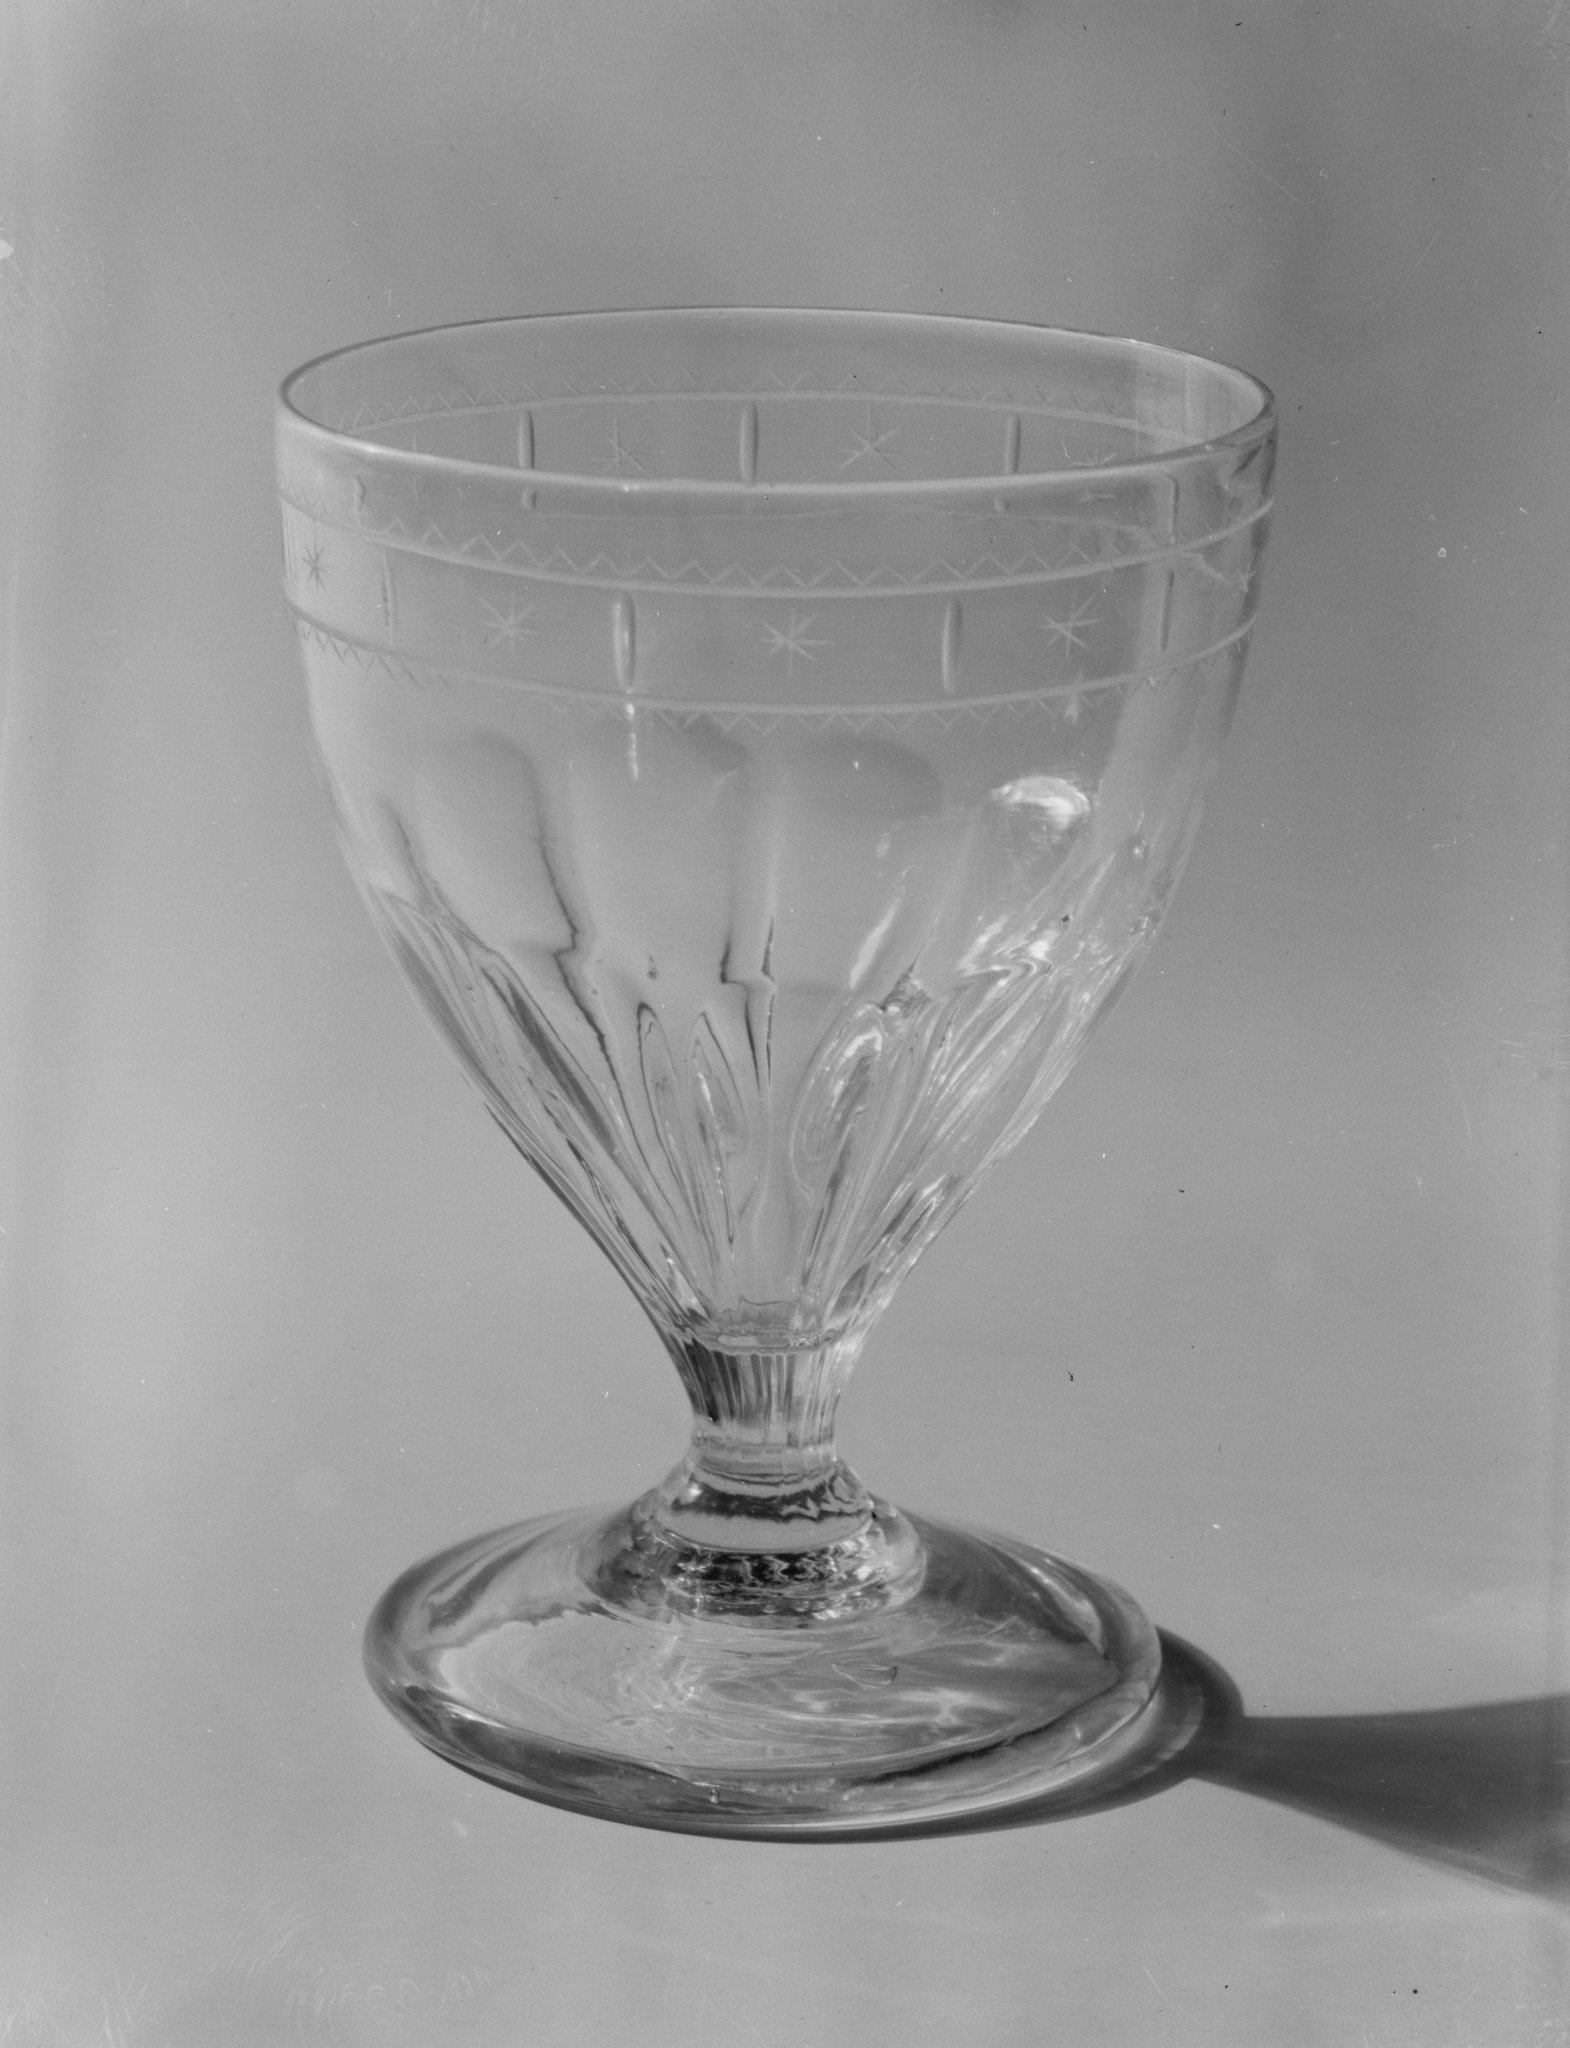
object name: goblet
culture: british or irish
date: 1800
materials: glass, lead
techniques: glassblowing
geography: ireland